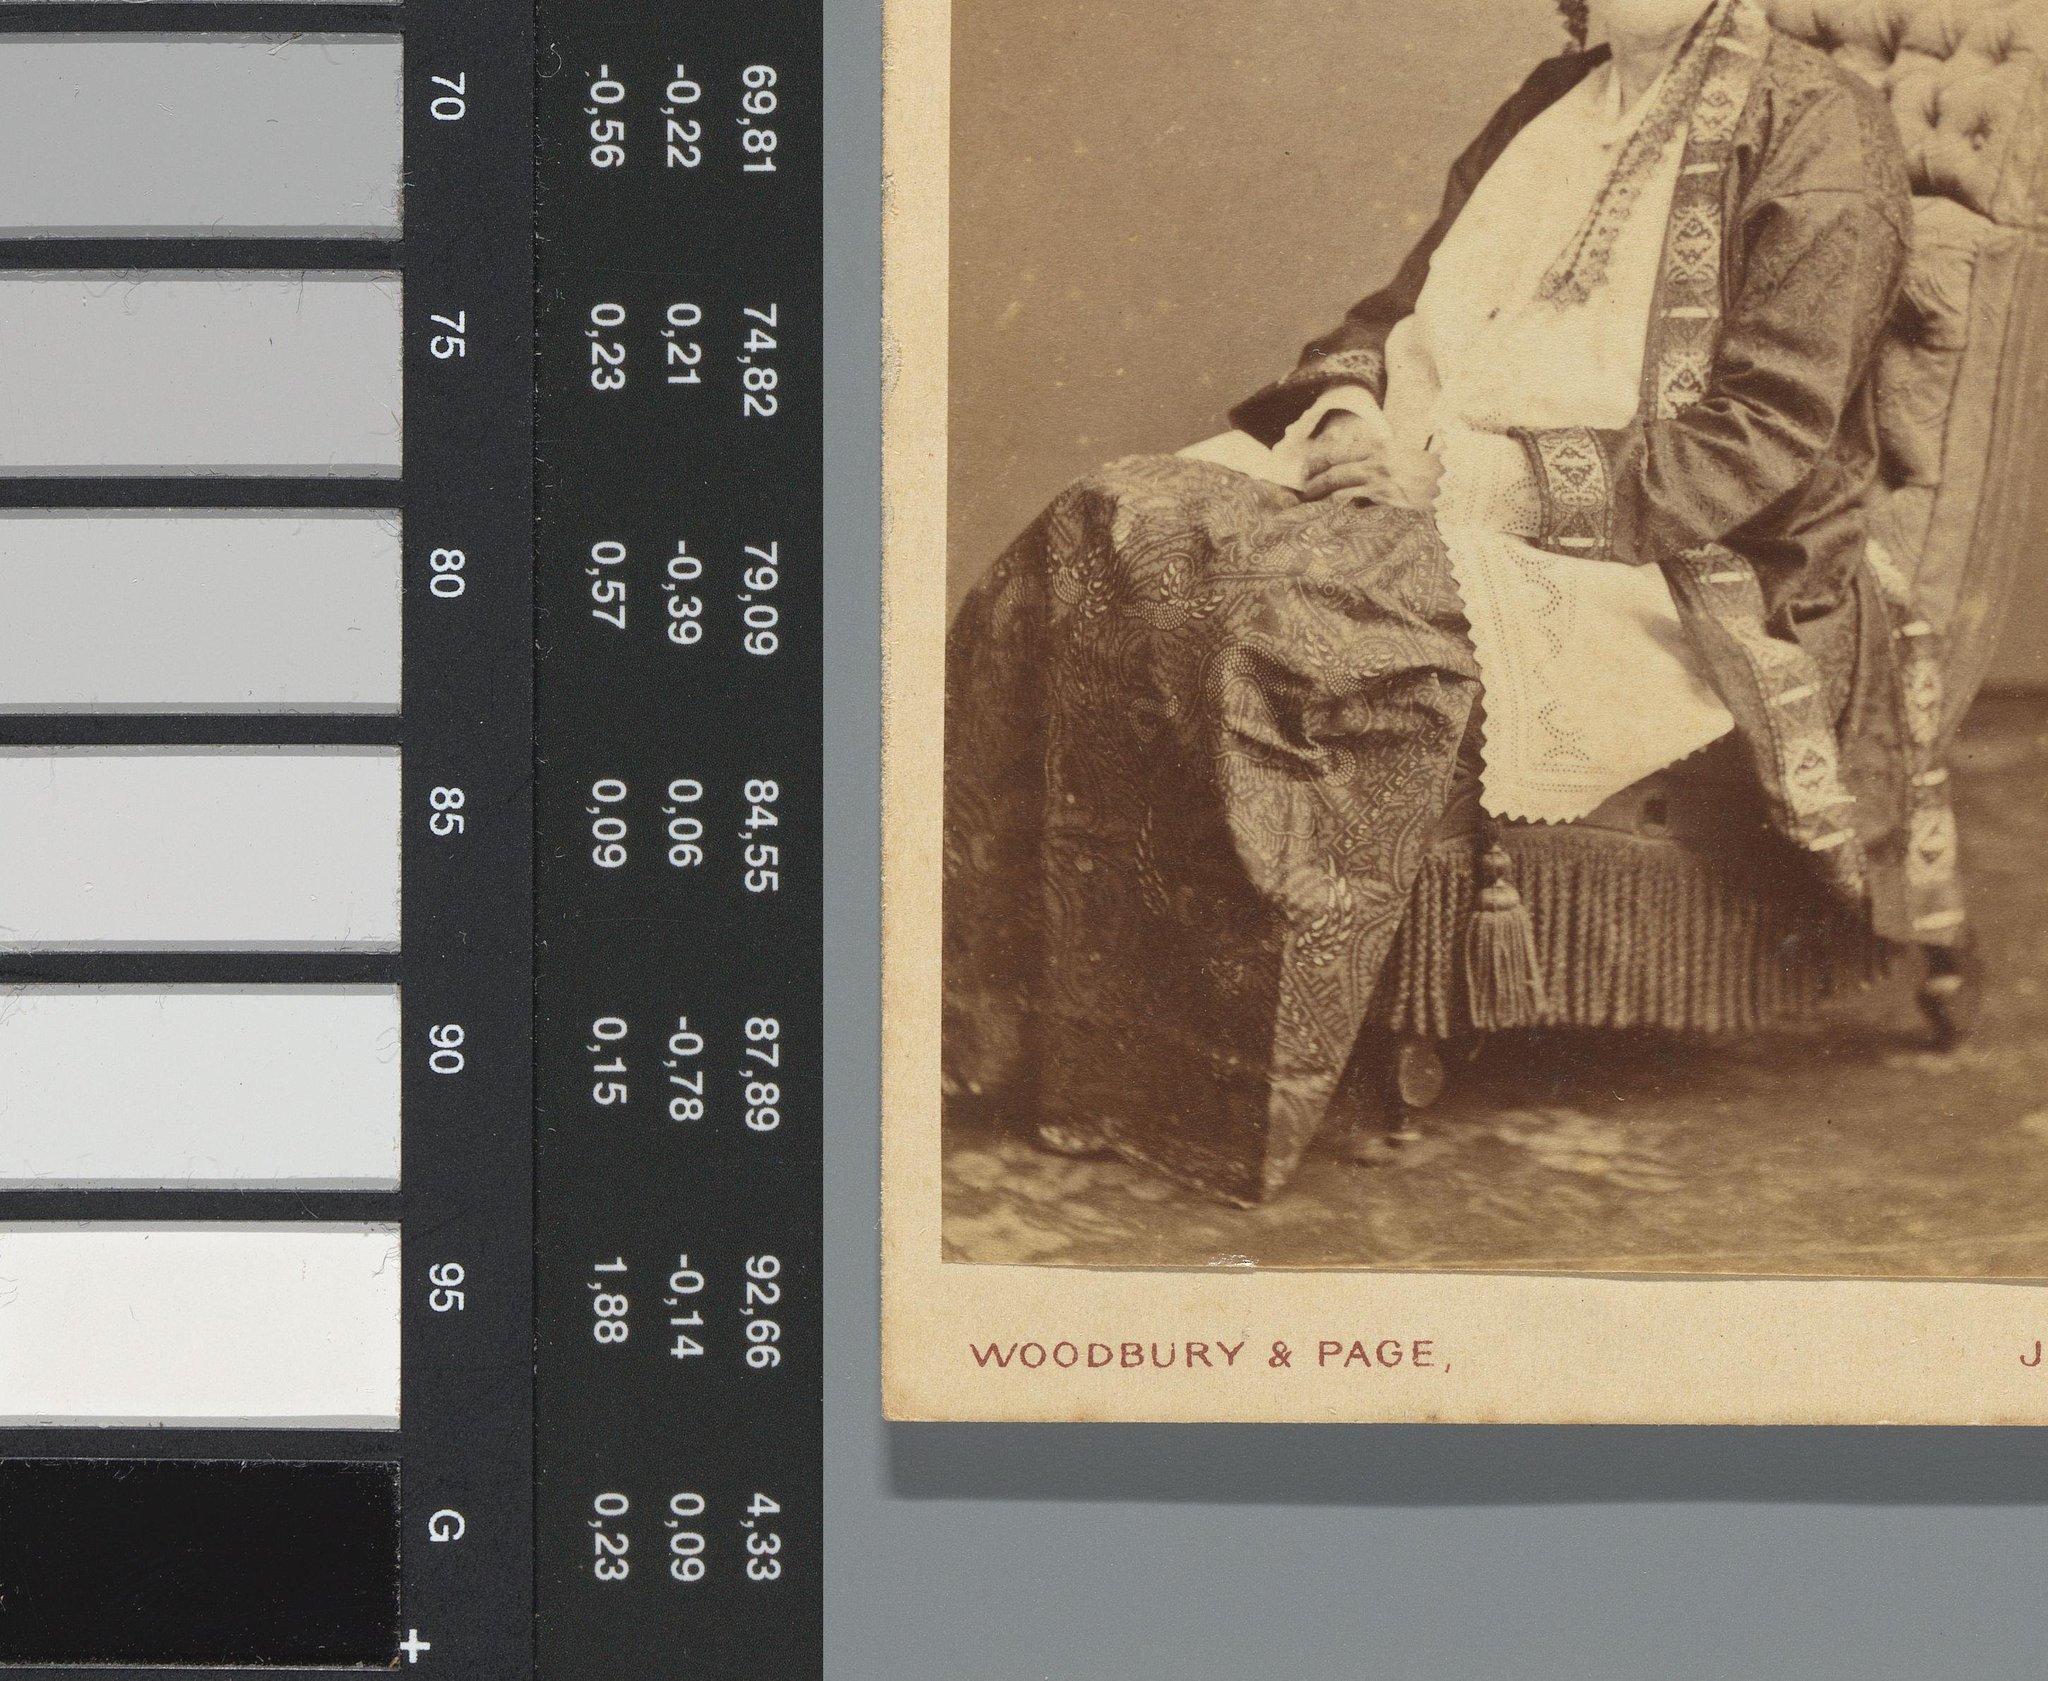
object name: photograph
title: Portret van Alexandrina Albertina van der Hucht-Holle, zittend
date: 1860-1877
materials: cardboard, photographic support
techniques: albumen print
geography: java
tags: alexandrina albertina van der hucht-holle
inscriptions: name: ‘WOODBURY & PAGE, / JAVA’, inscription: ‘Alexandrina Albertina / van der Hucht, echtgen. / van Pieter Holle’, inscription: ‘Overgrootmoeder 1802 - Holle / 1877 v.d. Hucht’, name: ‘WOODBURY & PAGE / PHOTOGRAPHERS / JAVA’